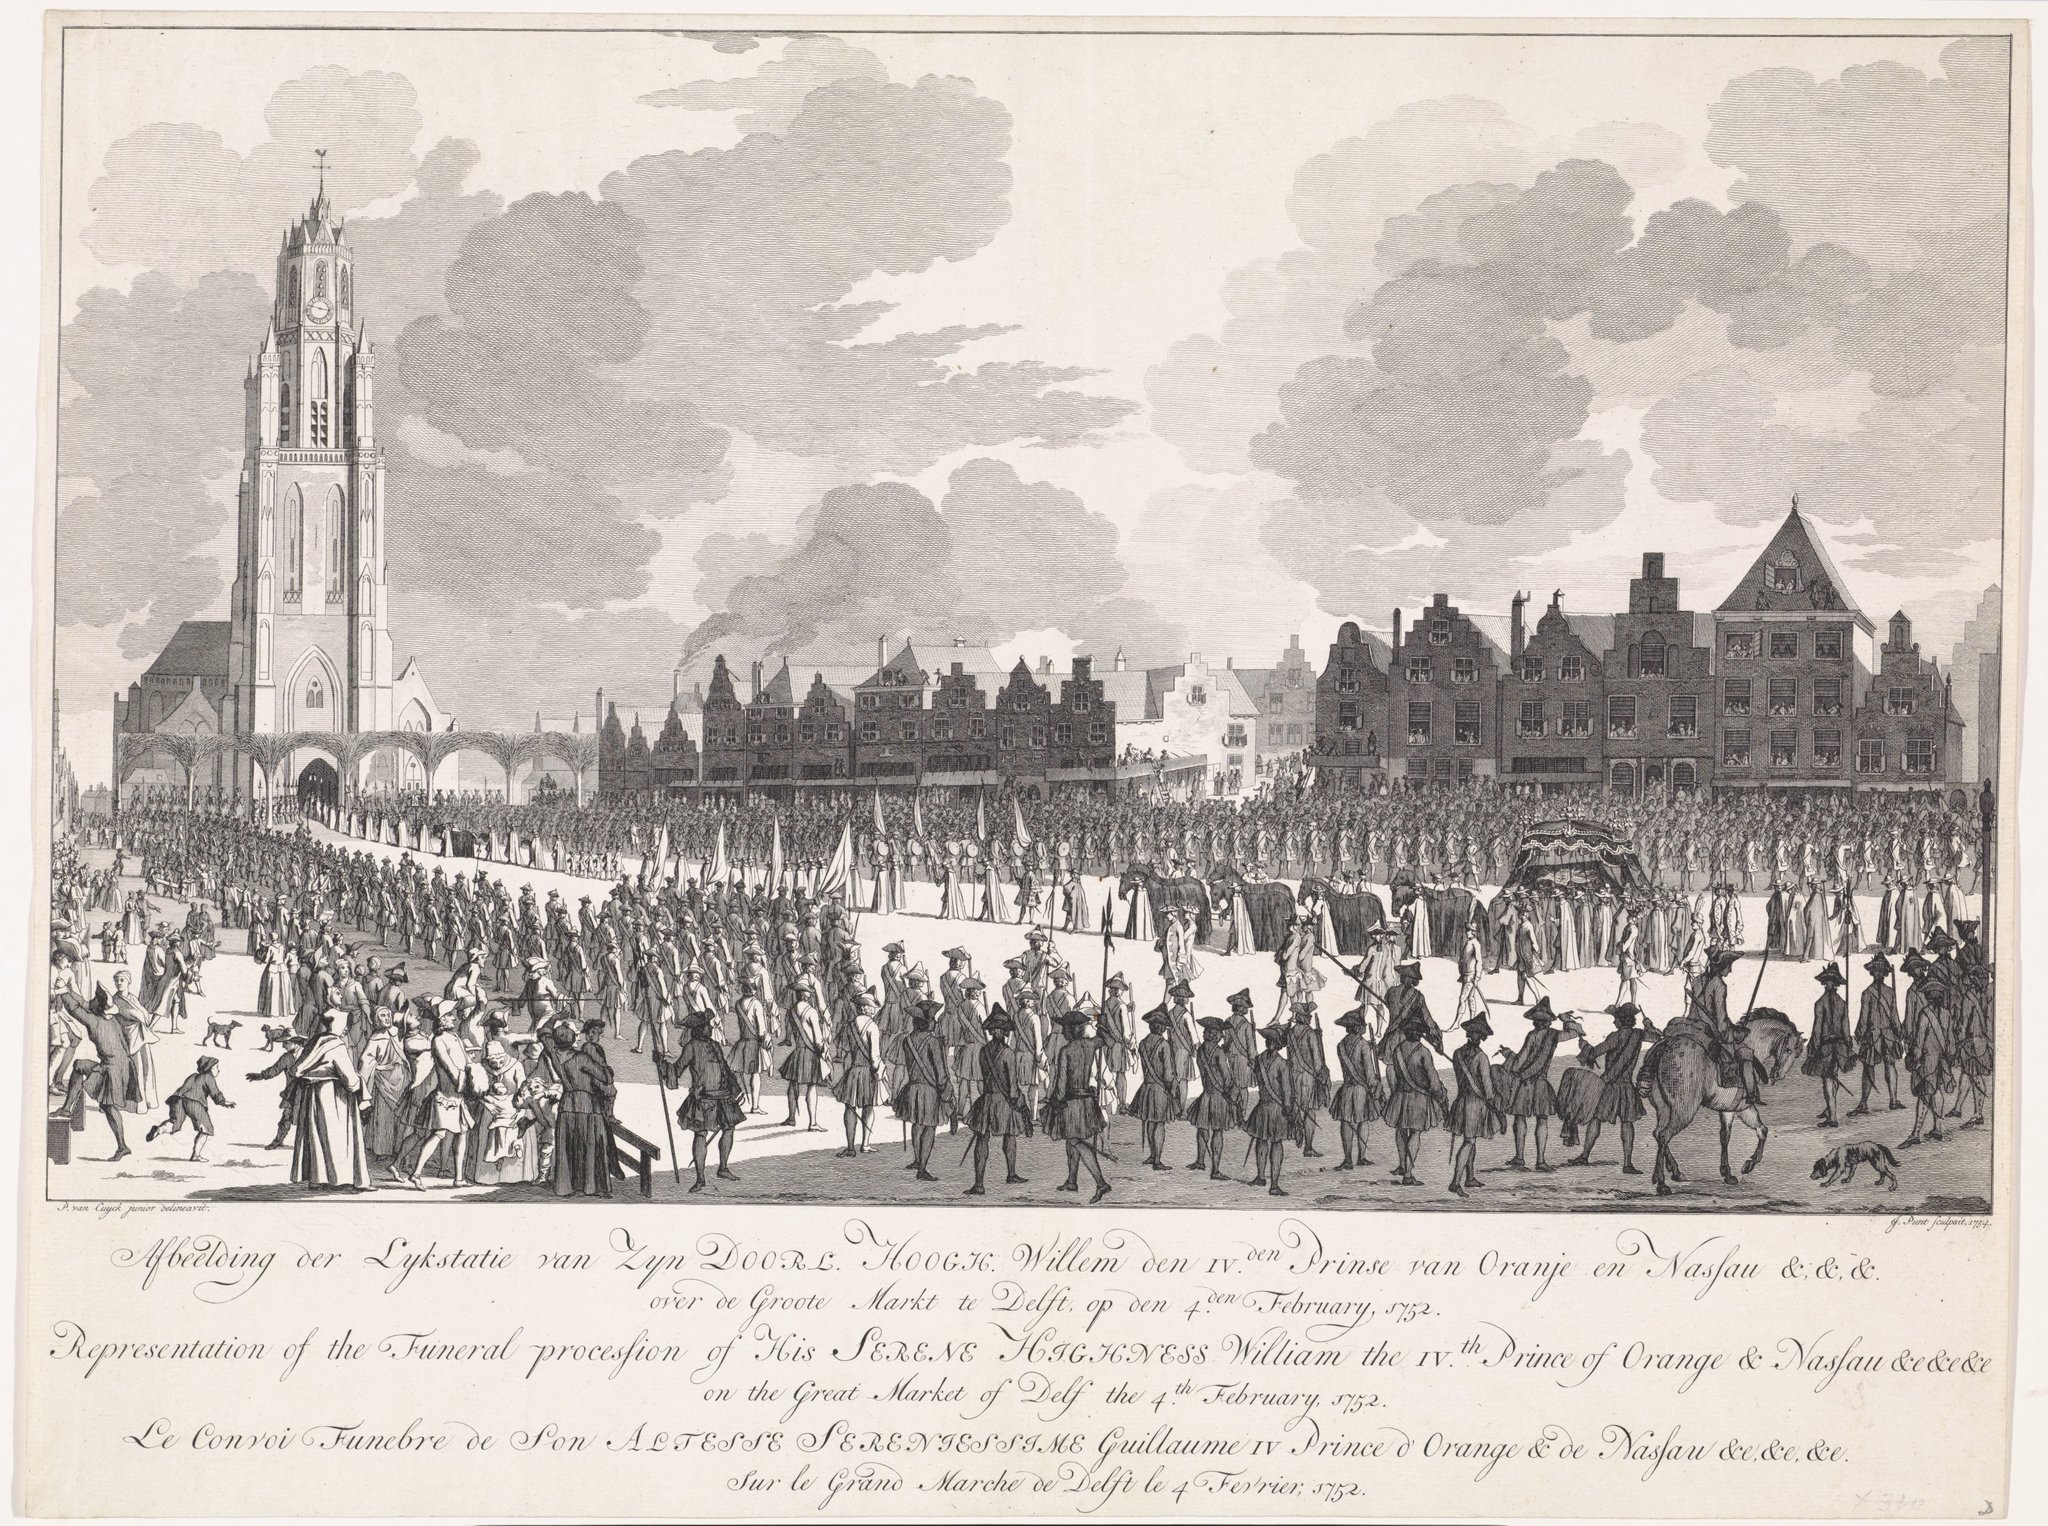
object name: print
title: Afbeelding der Lykstatie van Zyn Doorl. Hoogh. Willem den IV.den Prinse van Oranje en Nassau &,&,&. over de Groote Markt te Delft, op den 4.den February 1752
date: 1754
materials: paper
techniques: etching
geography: amsterdam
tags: the hague, willem iv (prins van oranje-nassau), cortege, funeral procession, delft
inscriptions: collector's mark: Lugt 2228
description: Aankomst van de rouwstoet met de lijkwagen op de Grote Markt te Delft en de intocht in de Nieuwe Kerk. In de marge het onderschrift in Nederlands, Frans en Duits. Onderdeel van een serie van 41 platen van de begrafenisstoet van stadhouder Willem IV te Delft op 4 februari 1752.